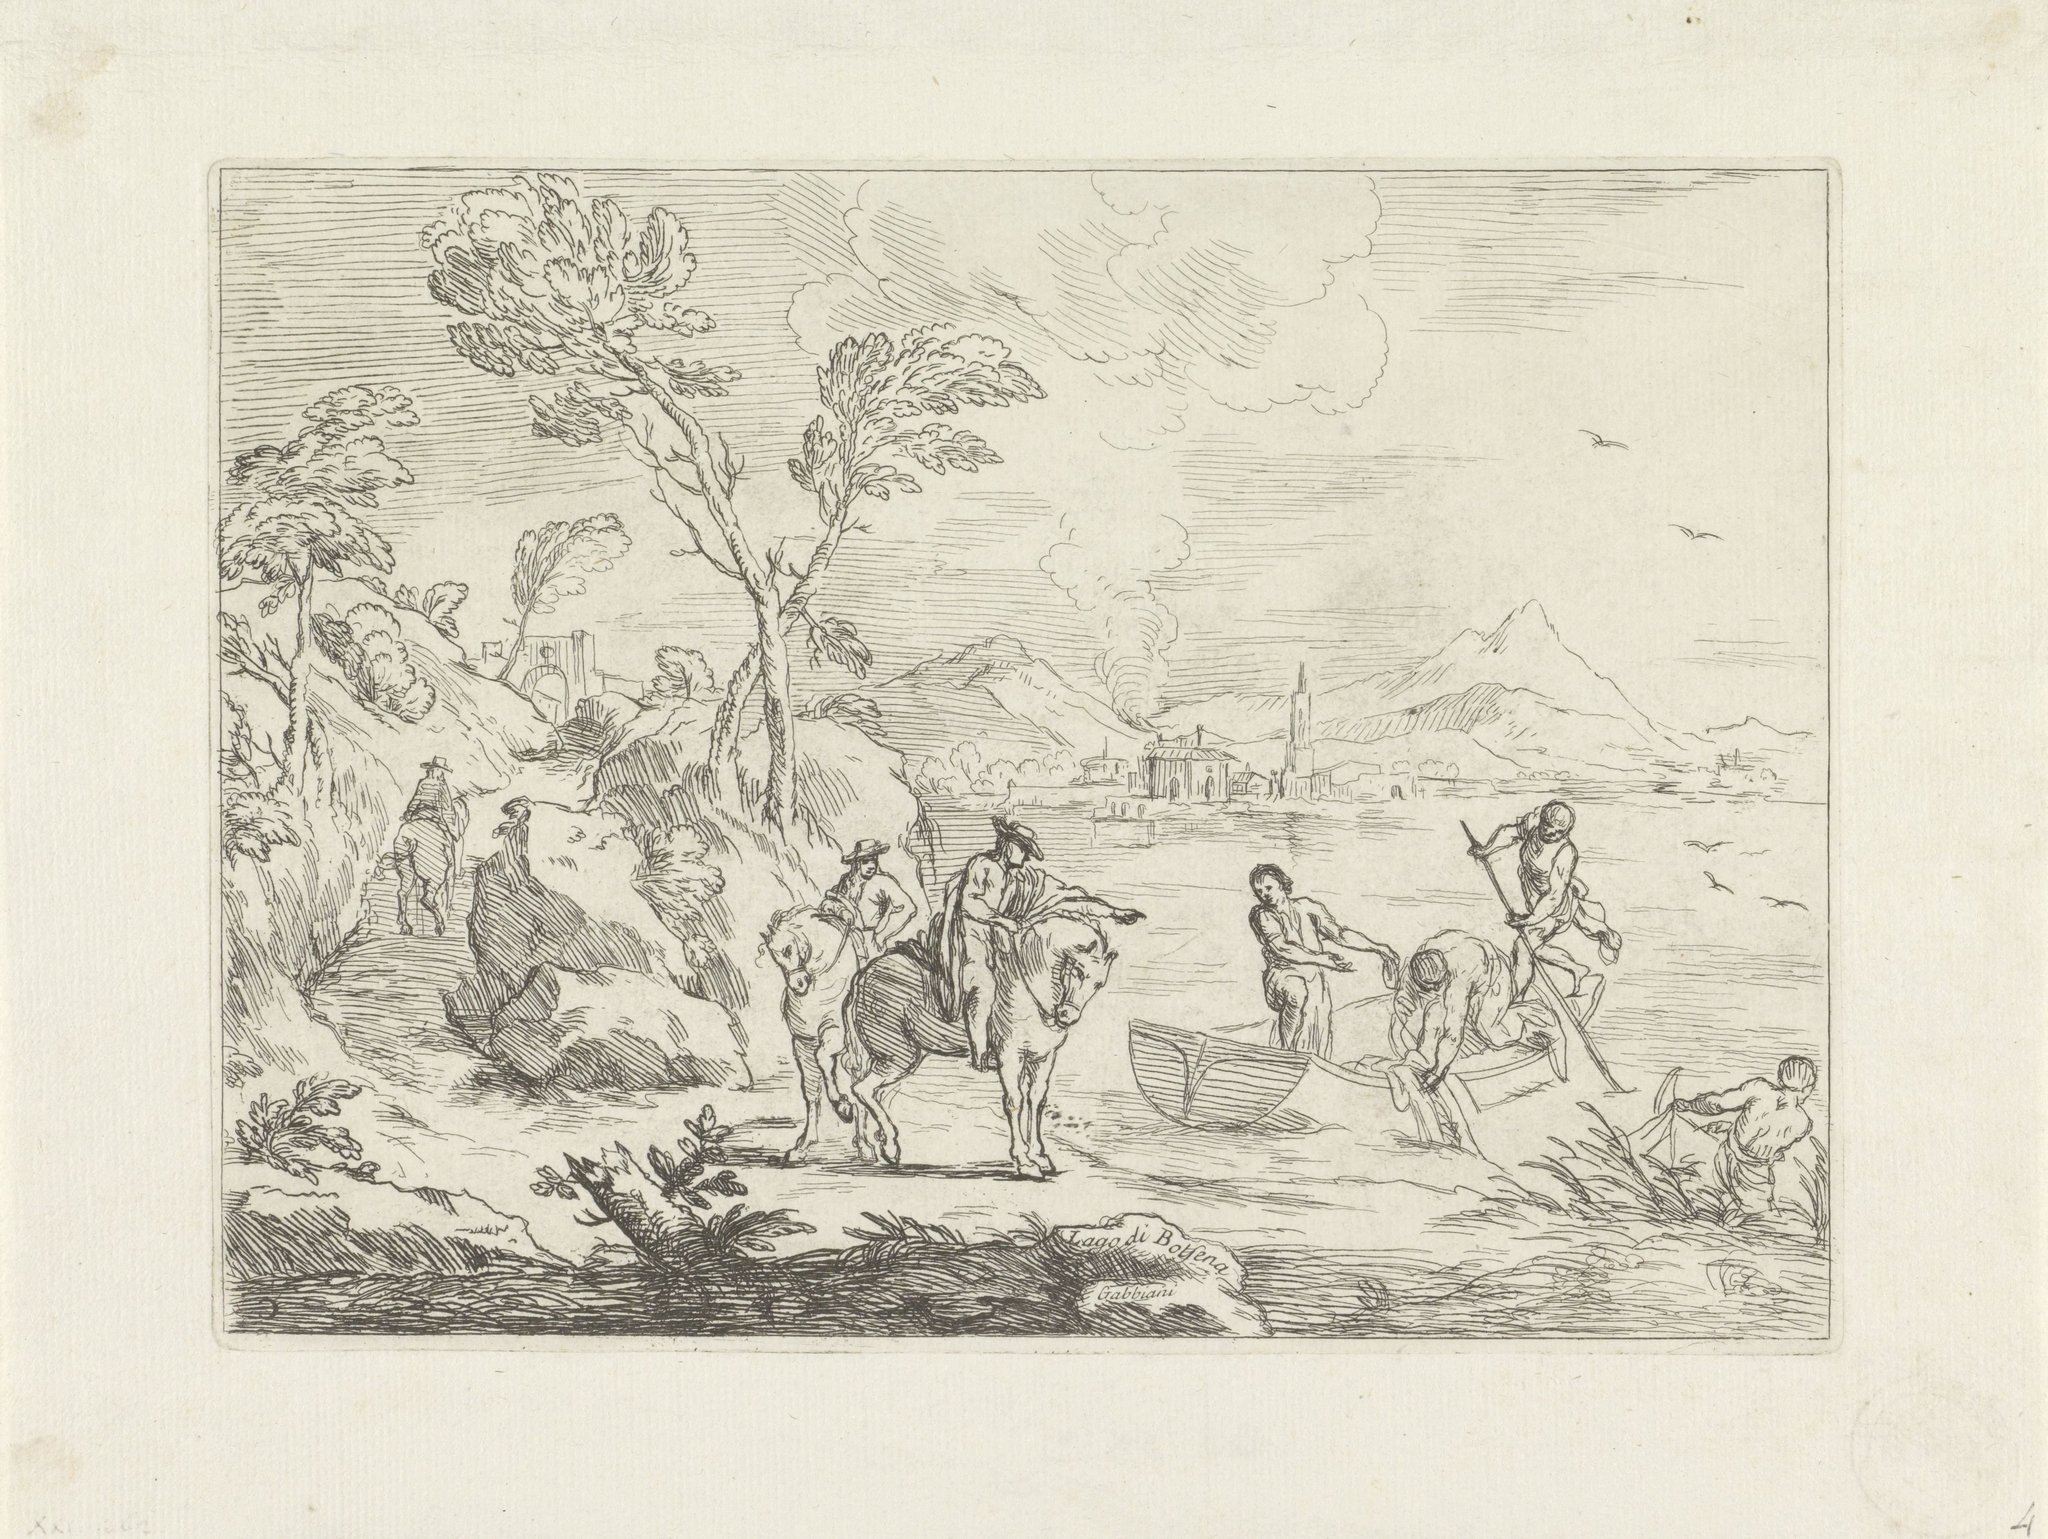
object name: print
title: Lago di Bolsena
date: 1662-1726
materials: paper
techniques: etching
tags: riding a horse, ass, or mule; rider, horseman, fishing net, lake, fisherman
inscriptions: collector's mark: Lugt 240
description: Zicht op de oever van een meer met twee ruiters te paard. Een van de ruiters wijst op een vissersboot met drie mannen die een net binnenhalen.